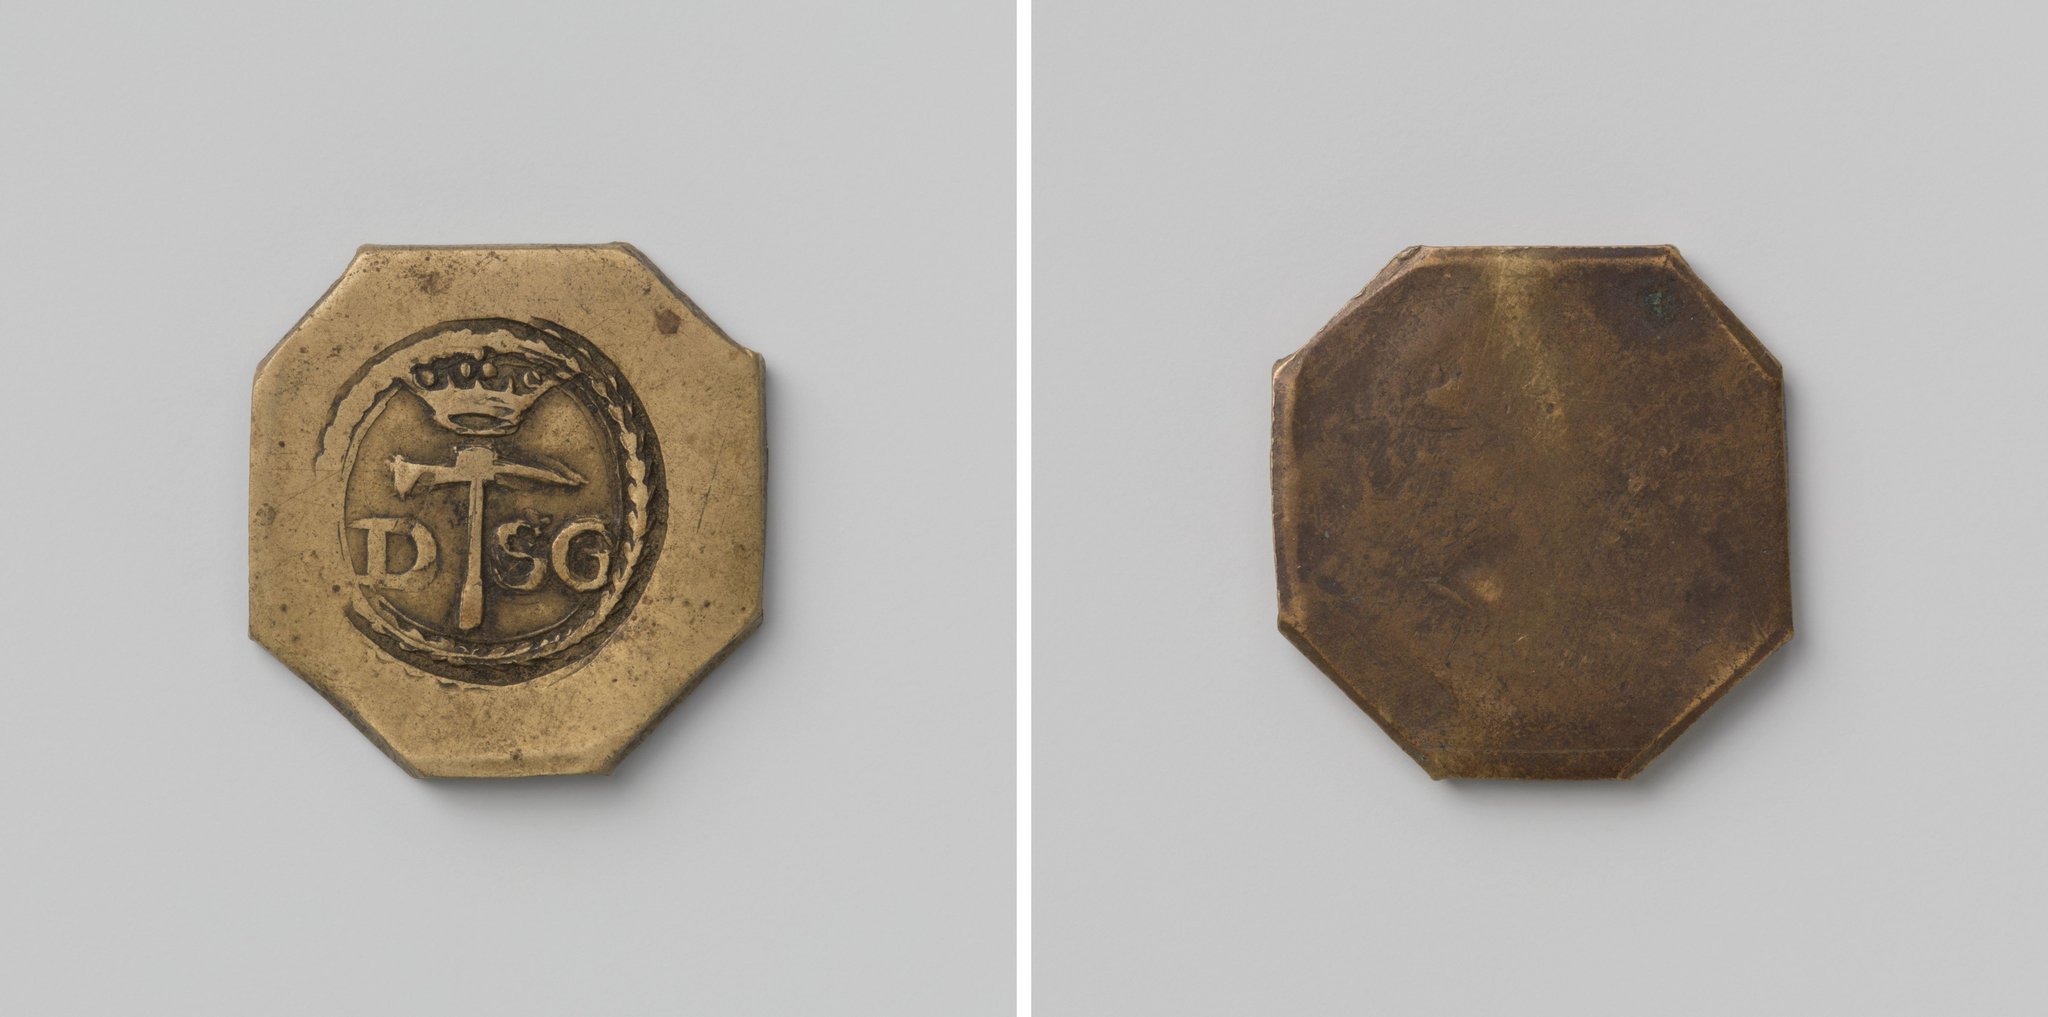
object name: medal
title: Gildepenning van het Smedengilde van Utrecht.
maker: Anonymous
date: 1600-1700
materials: brass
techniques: striking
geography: utrecht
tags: utrecht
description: Eenzijdige messing achthoekige penning. Voorzijde: gekroonde smidshamer tussen monogram van de letters D, S en G binnen ronde bladerkrans. Keerzijde: blanco